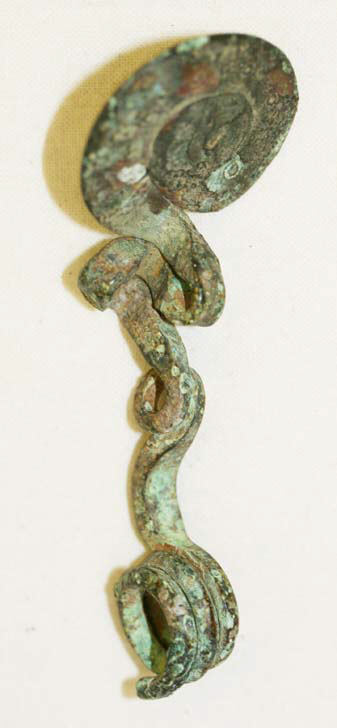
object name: pin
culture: european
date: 400-301 BCE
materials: bronze